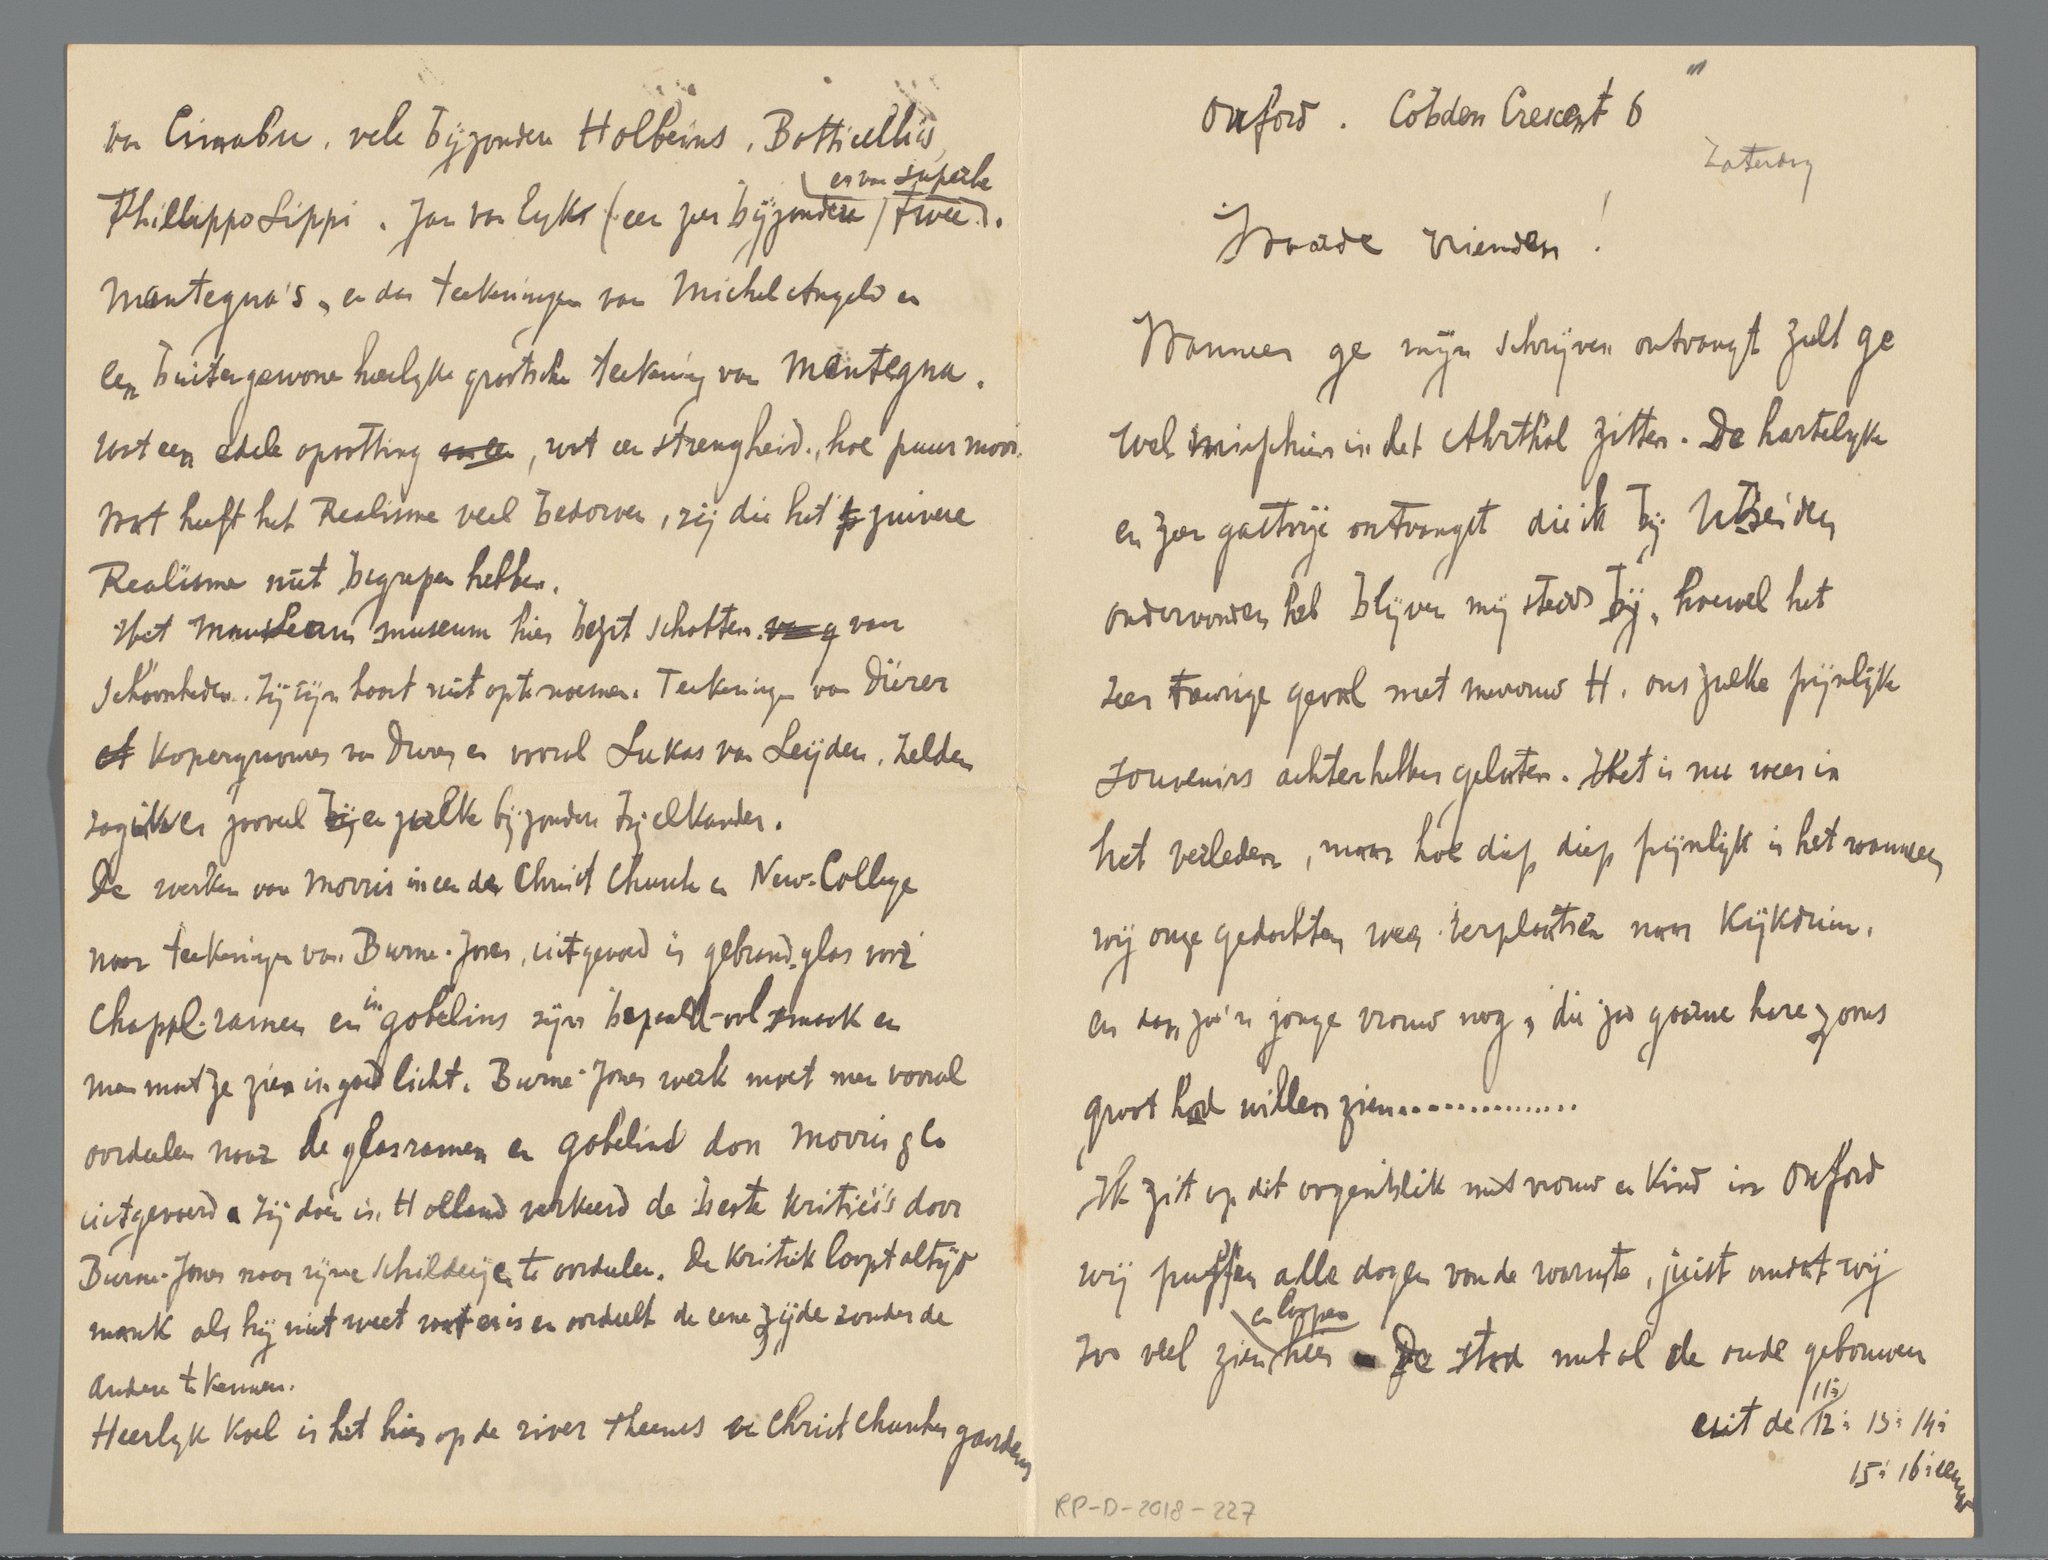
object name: letter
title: Brief van Jan Toorop te Oxford aan Jeannette Bouman-Stuyling de Lange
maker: jan toorop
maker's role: draughtsman, painter, print maker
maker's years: 1858-1928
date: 1899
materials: ink, paper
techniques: pen, writing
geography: oxford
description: Brief gericht aan Den Weledelgeboren en Mevrouw J. Bouman de Lange, Villa Val d' Rena, van Stolkweg, Scheveningen, Holland. Opschrift: beantwoord op 18 aug 1899.